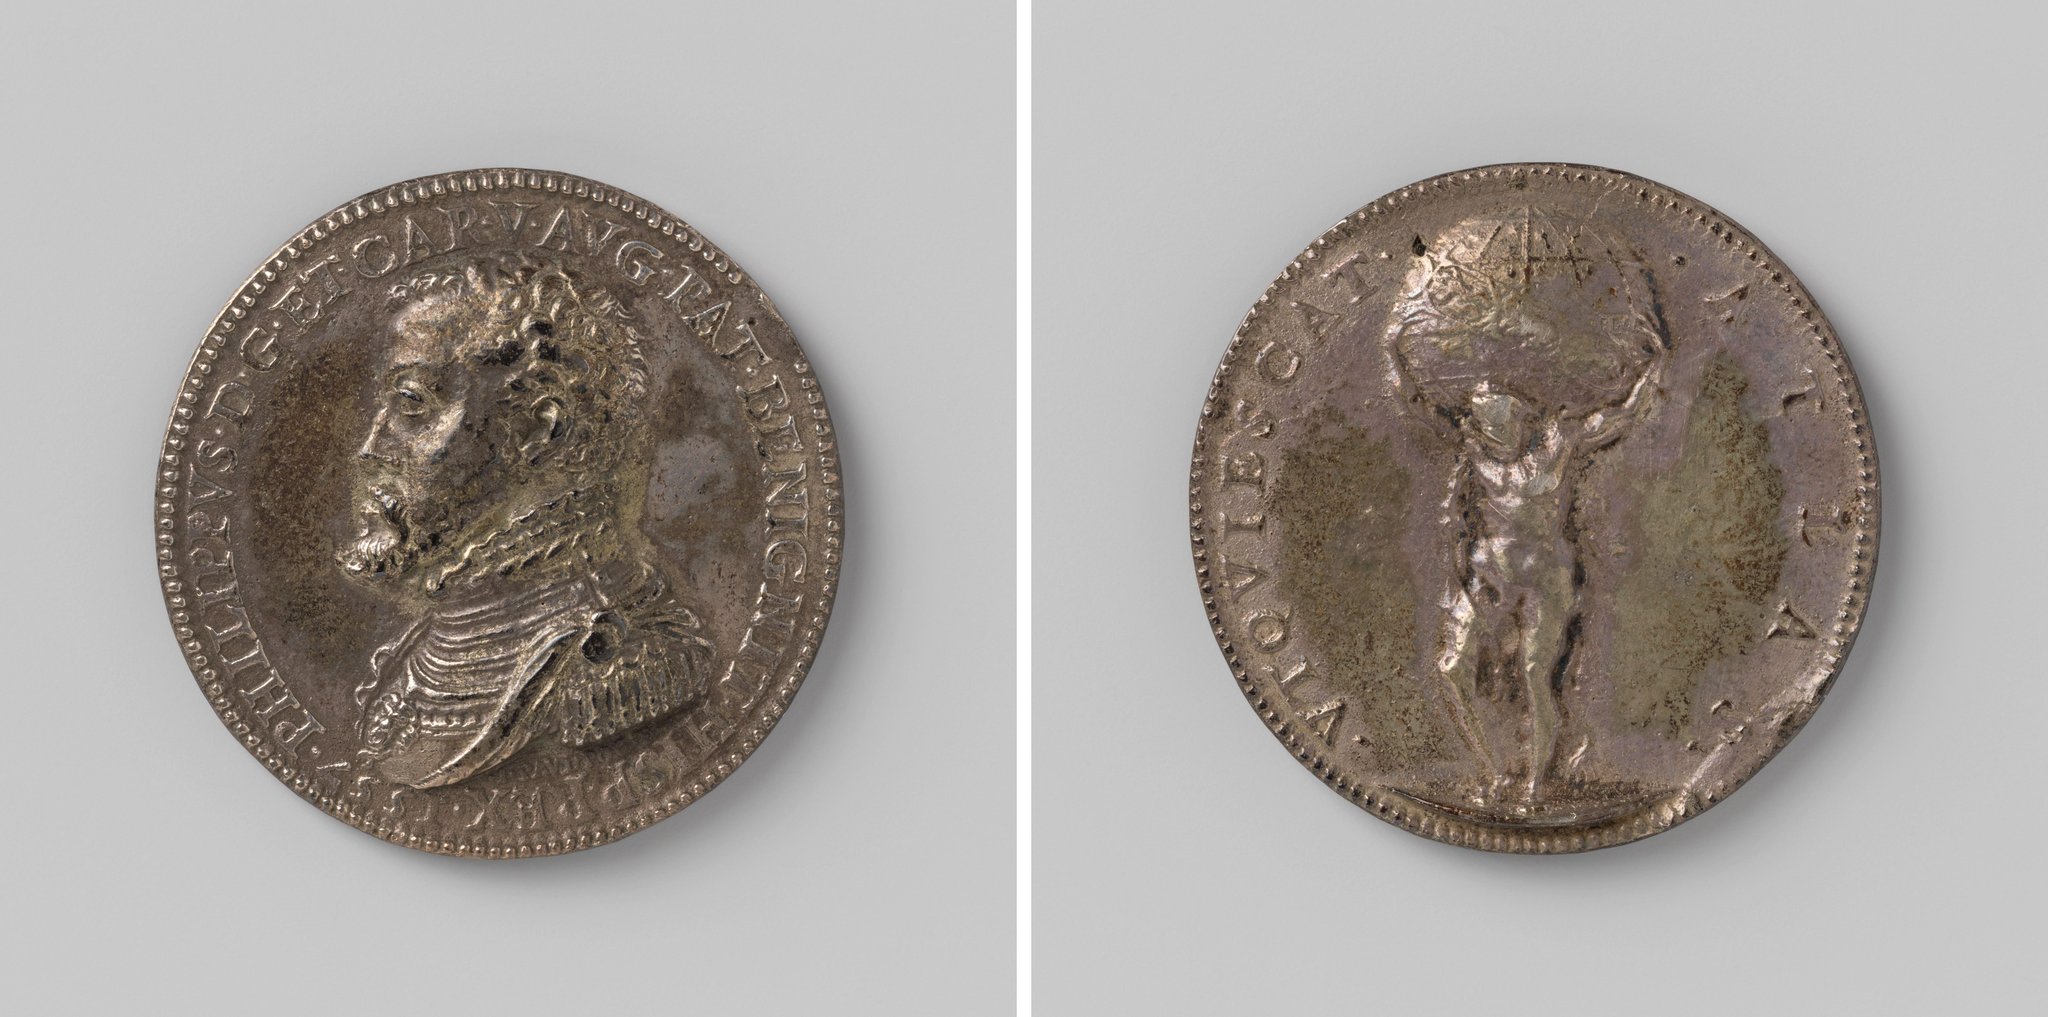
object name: history medal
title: Overdracht van de regering aan Filips II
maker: gianpaolo poggini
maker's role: medailleur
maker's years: 1518-1582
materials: silver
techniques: casting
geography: antwerp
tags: philip ii of spain, ghent, charles v (holy roman emperor and king of spain)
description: Zilveren penning. Voorzijde: borststuk man binnen omschrift. Keerzijde: Atlas torst werldbol binnen omschrift.